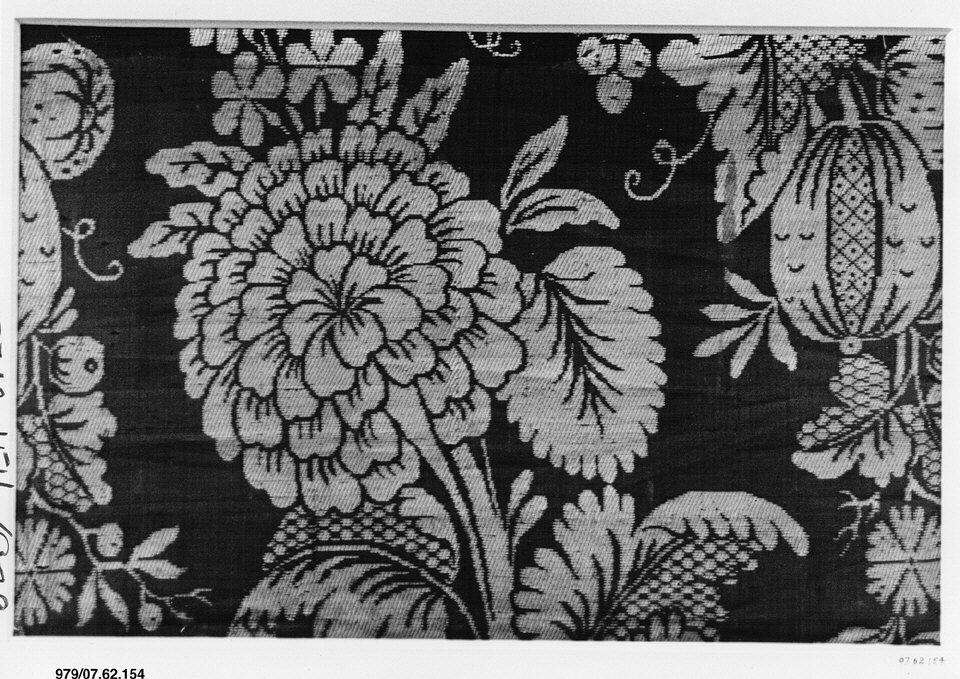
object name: piece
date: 1730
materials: silk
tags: flowers,leaves